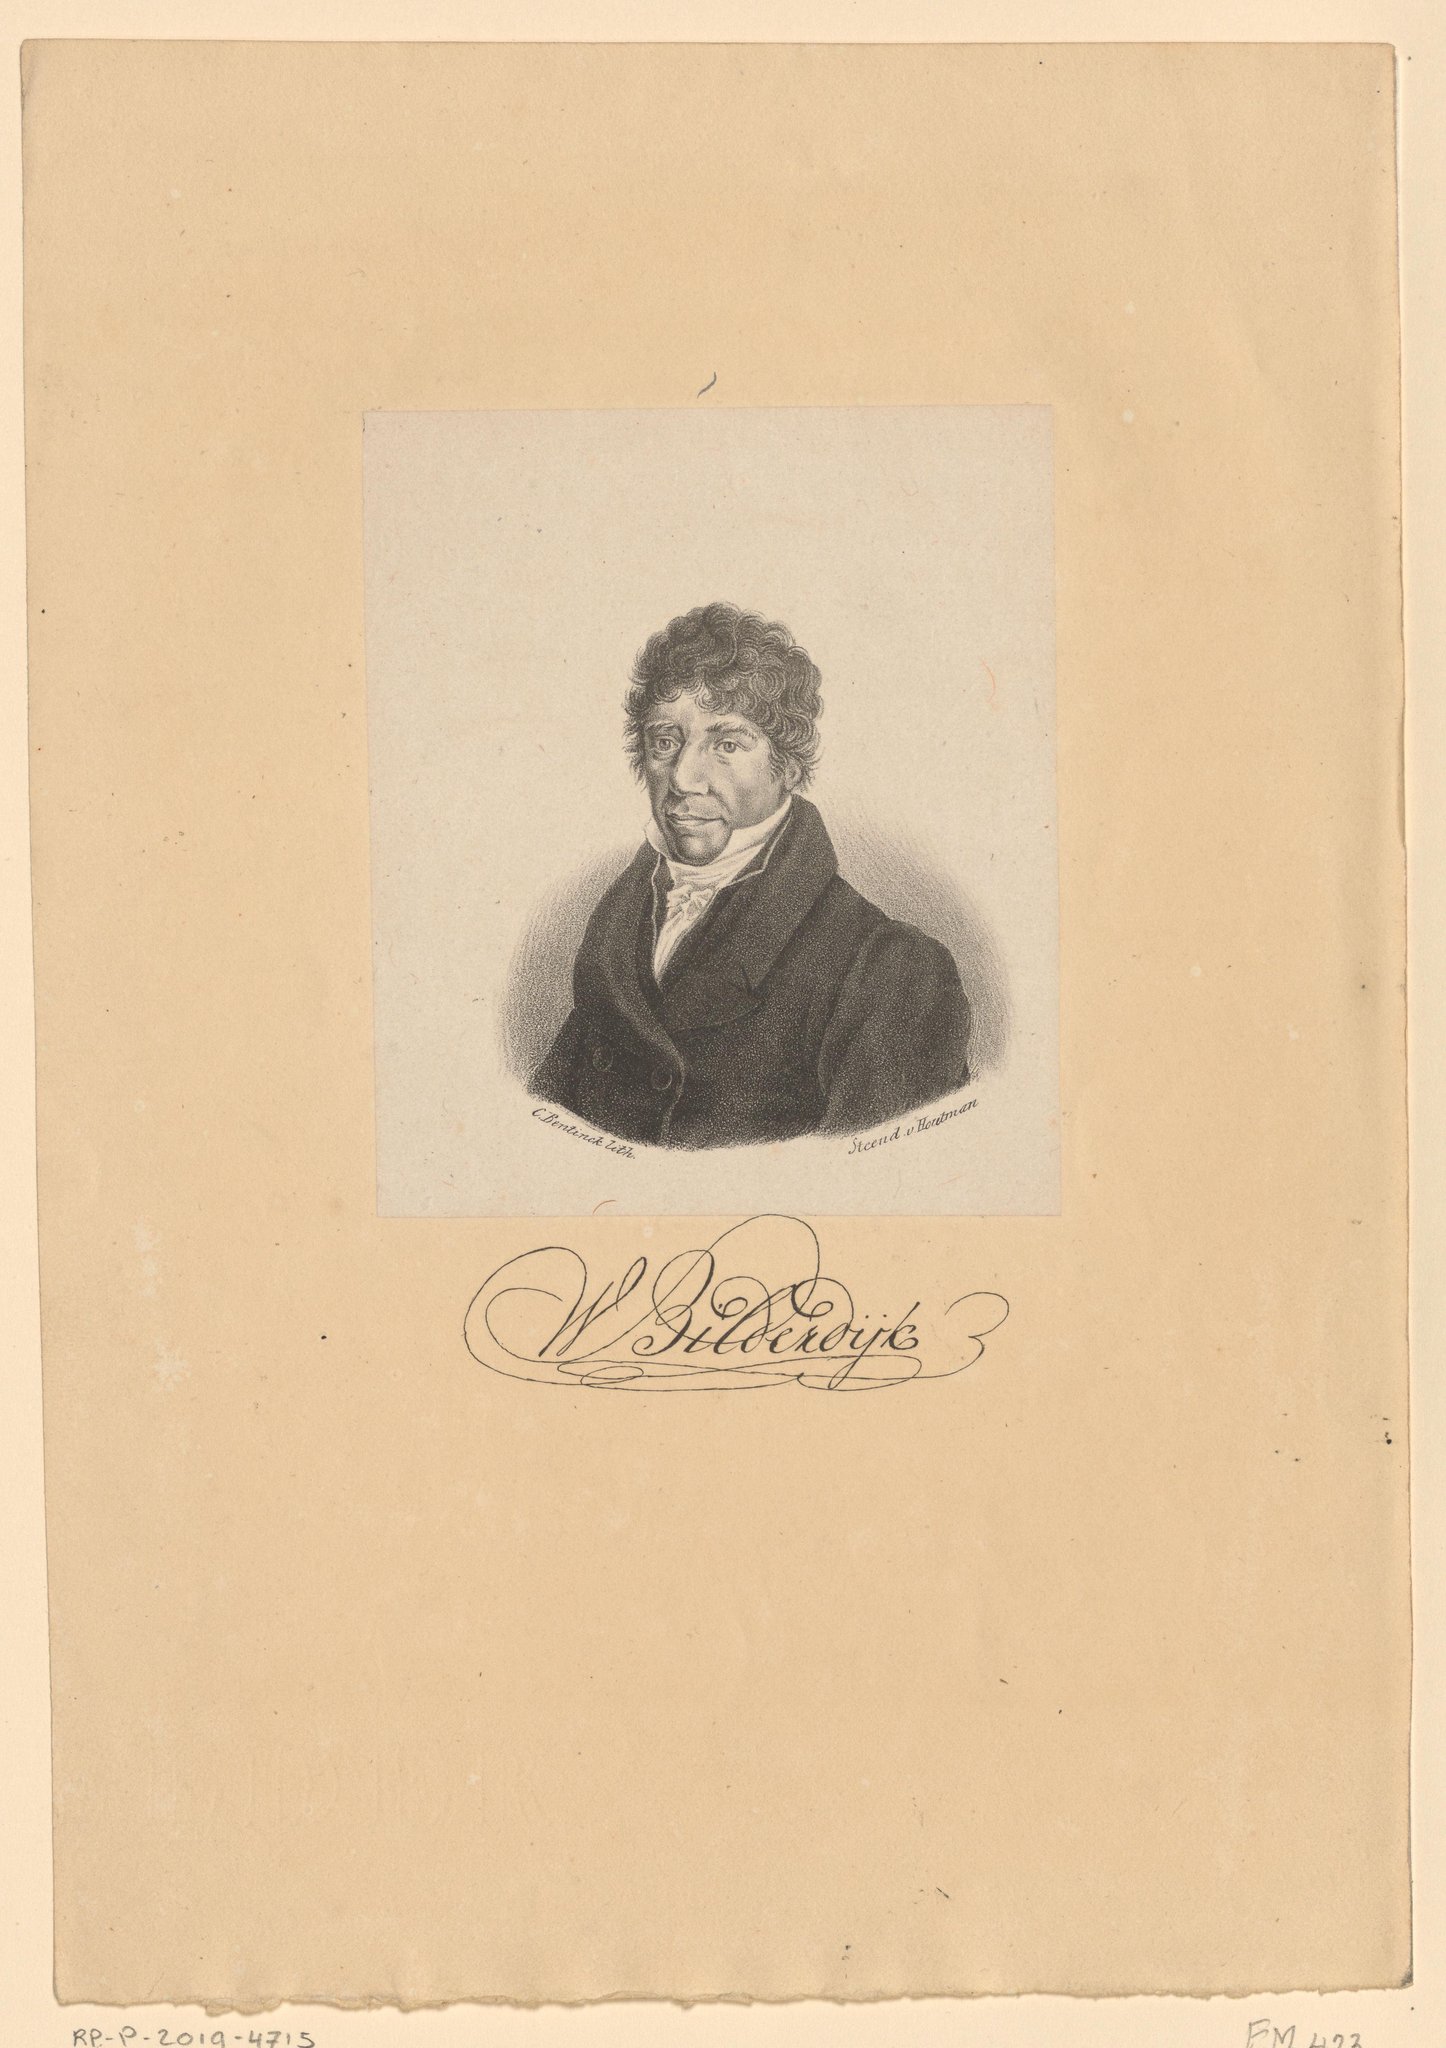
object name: print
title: Portret van Willem Bilderdijk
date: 1824-1843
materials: paper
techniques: lithograph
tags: haarlem, print maker, draughtsman, willem bilderdijk, historical persons, portrait of a writer